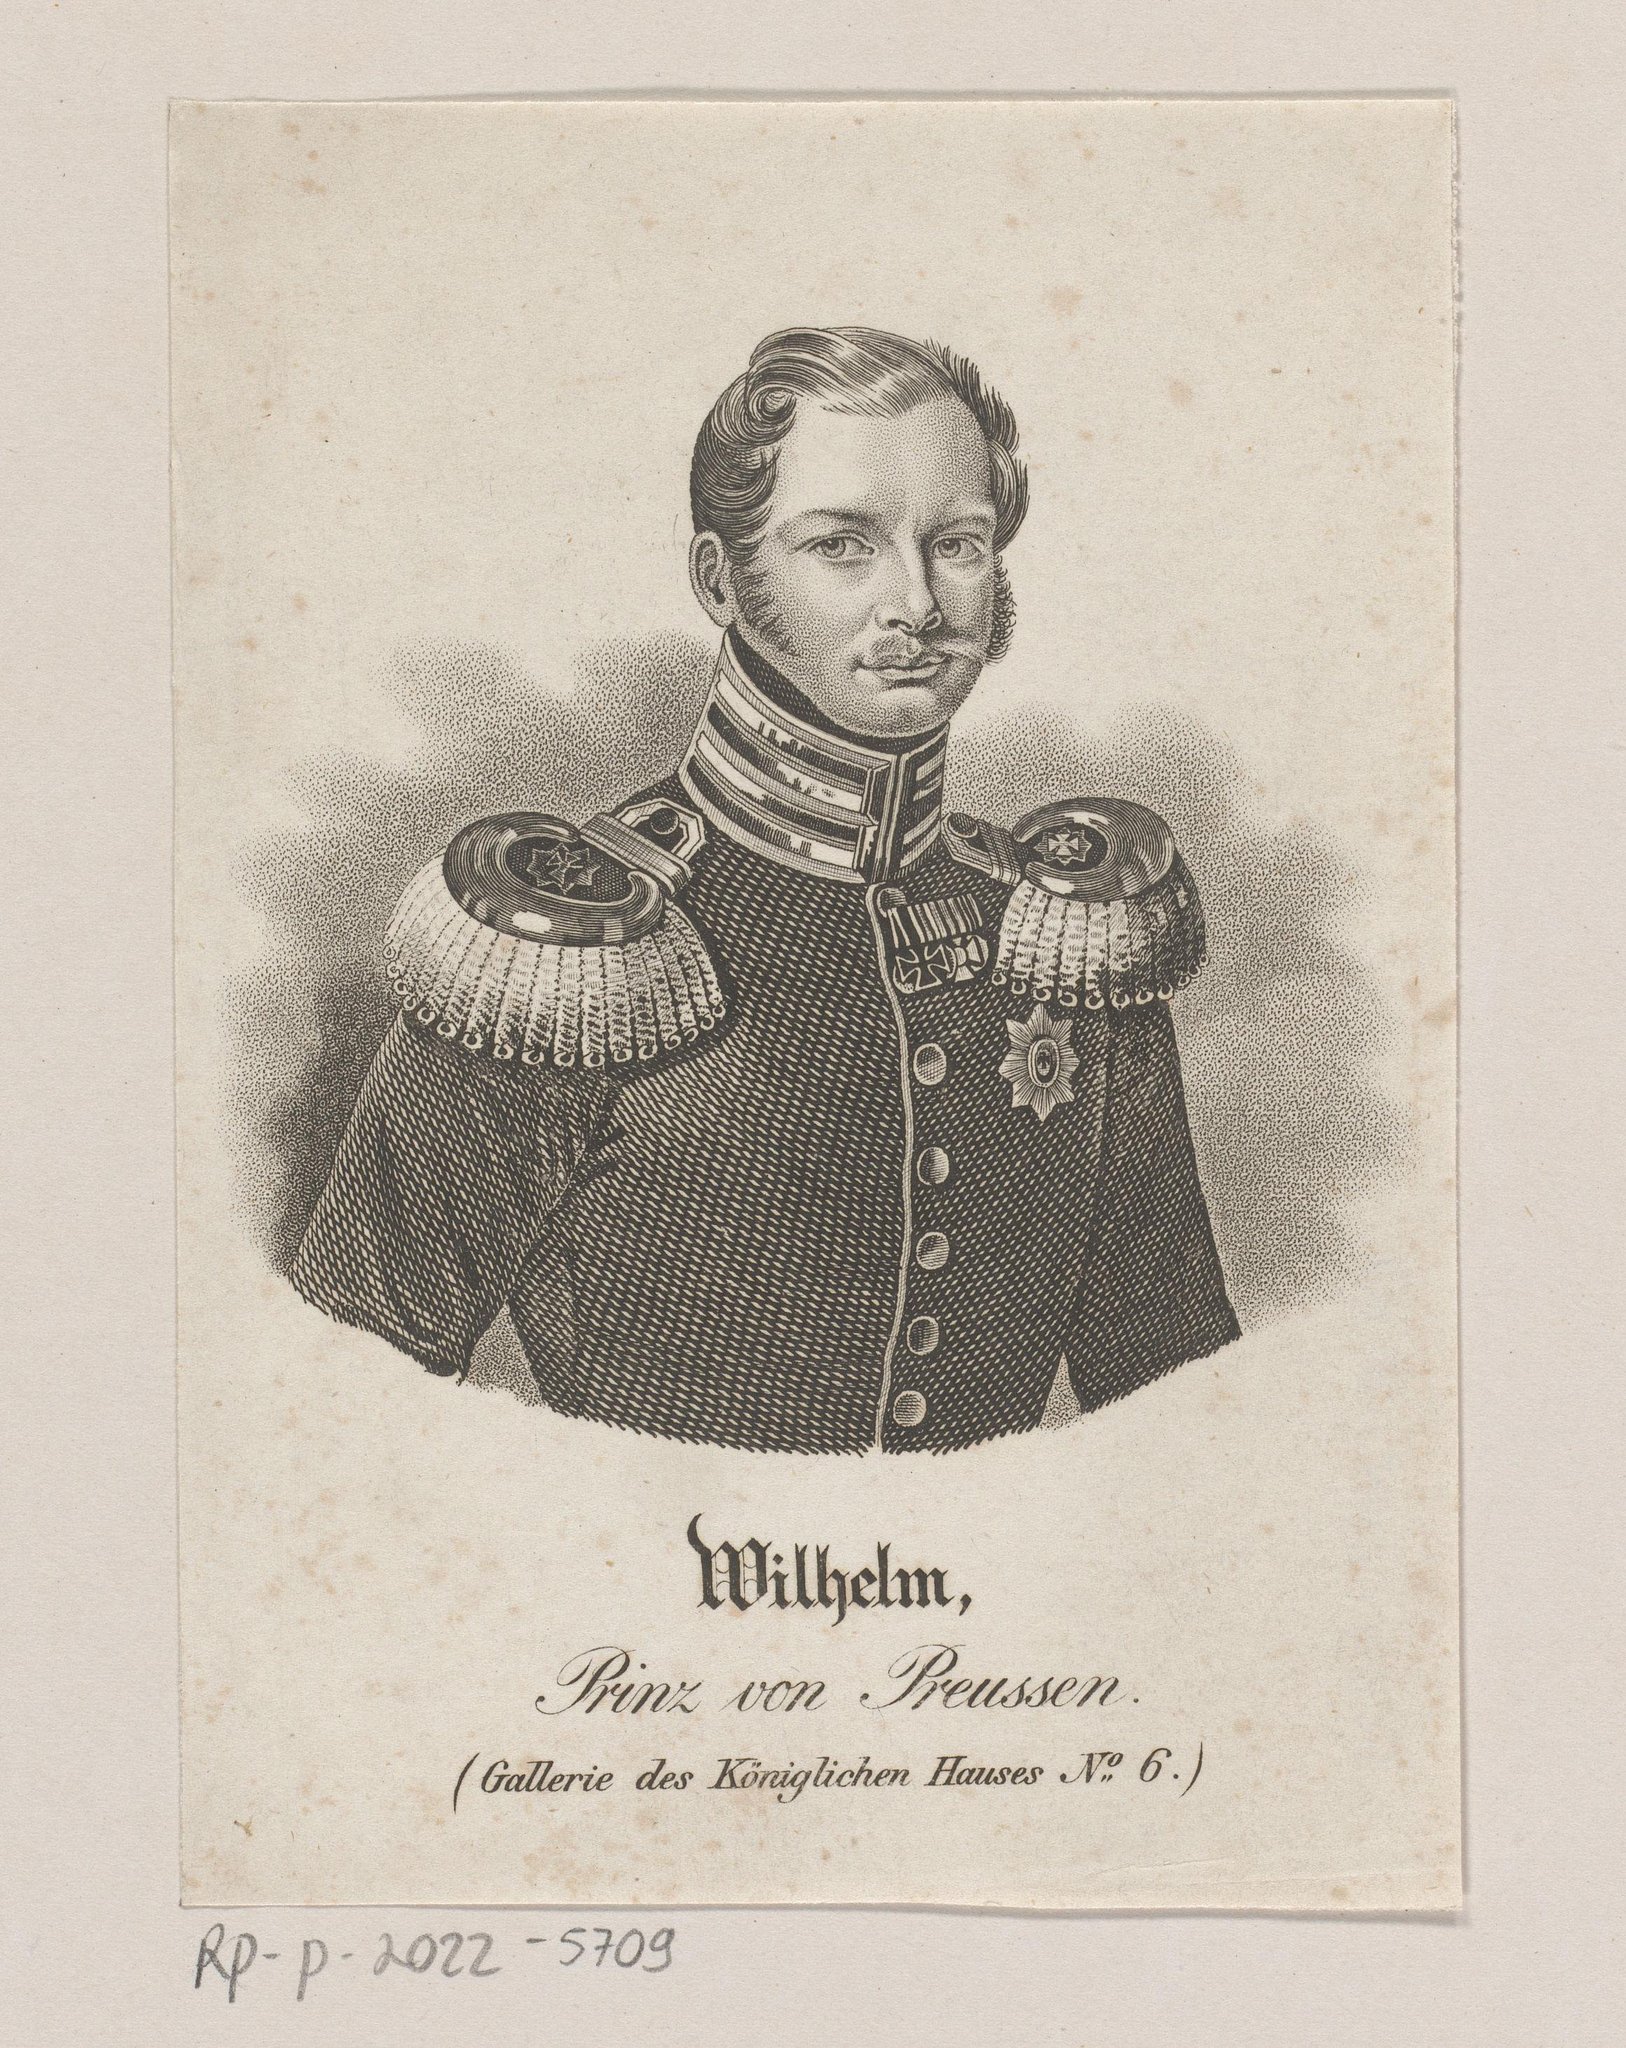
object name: print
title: Portret van Willem, prins van Pruisen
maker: Anonymous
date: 1800-1851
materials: paper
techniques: etching, roulette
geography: germany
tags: historical persons